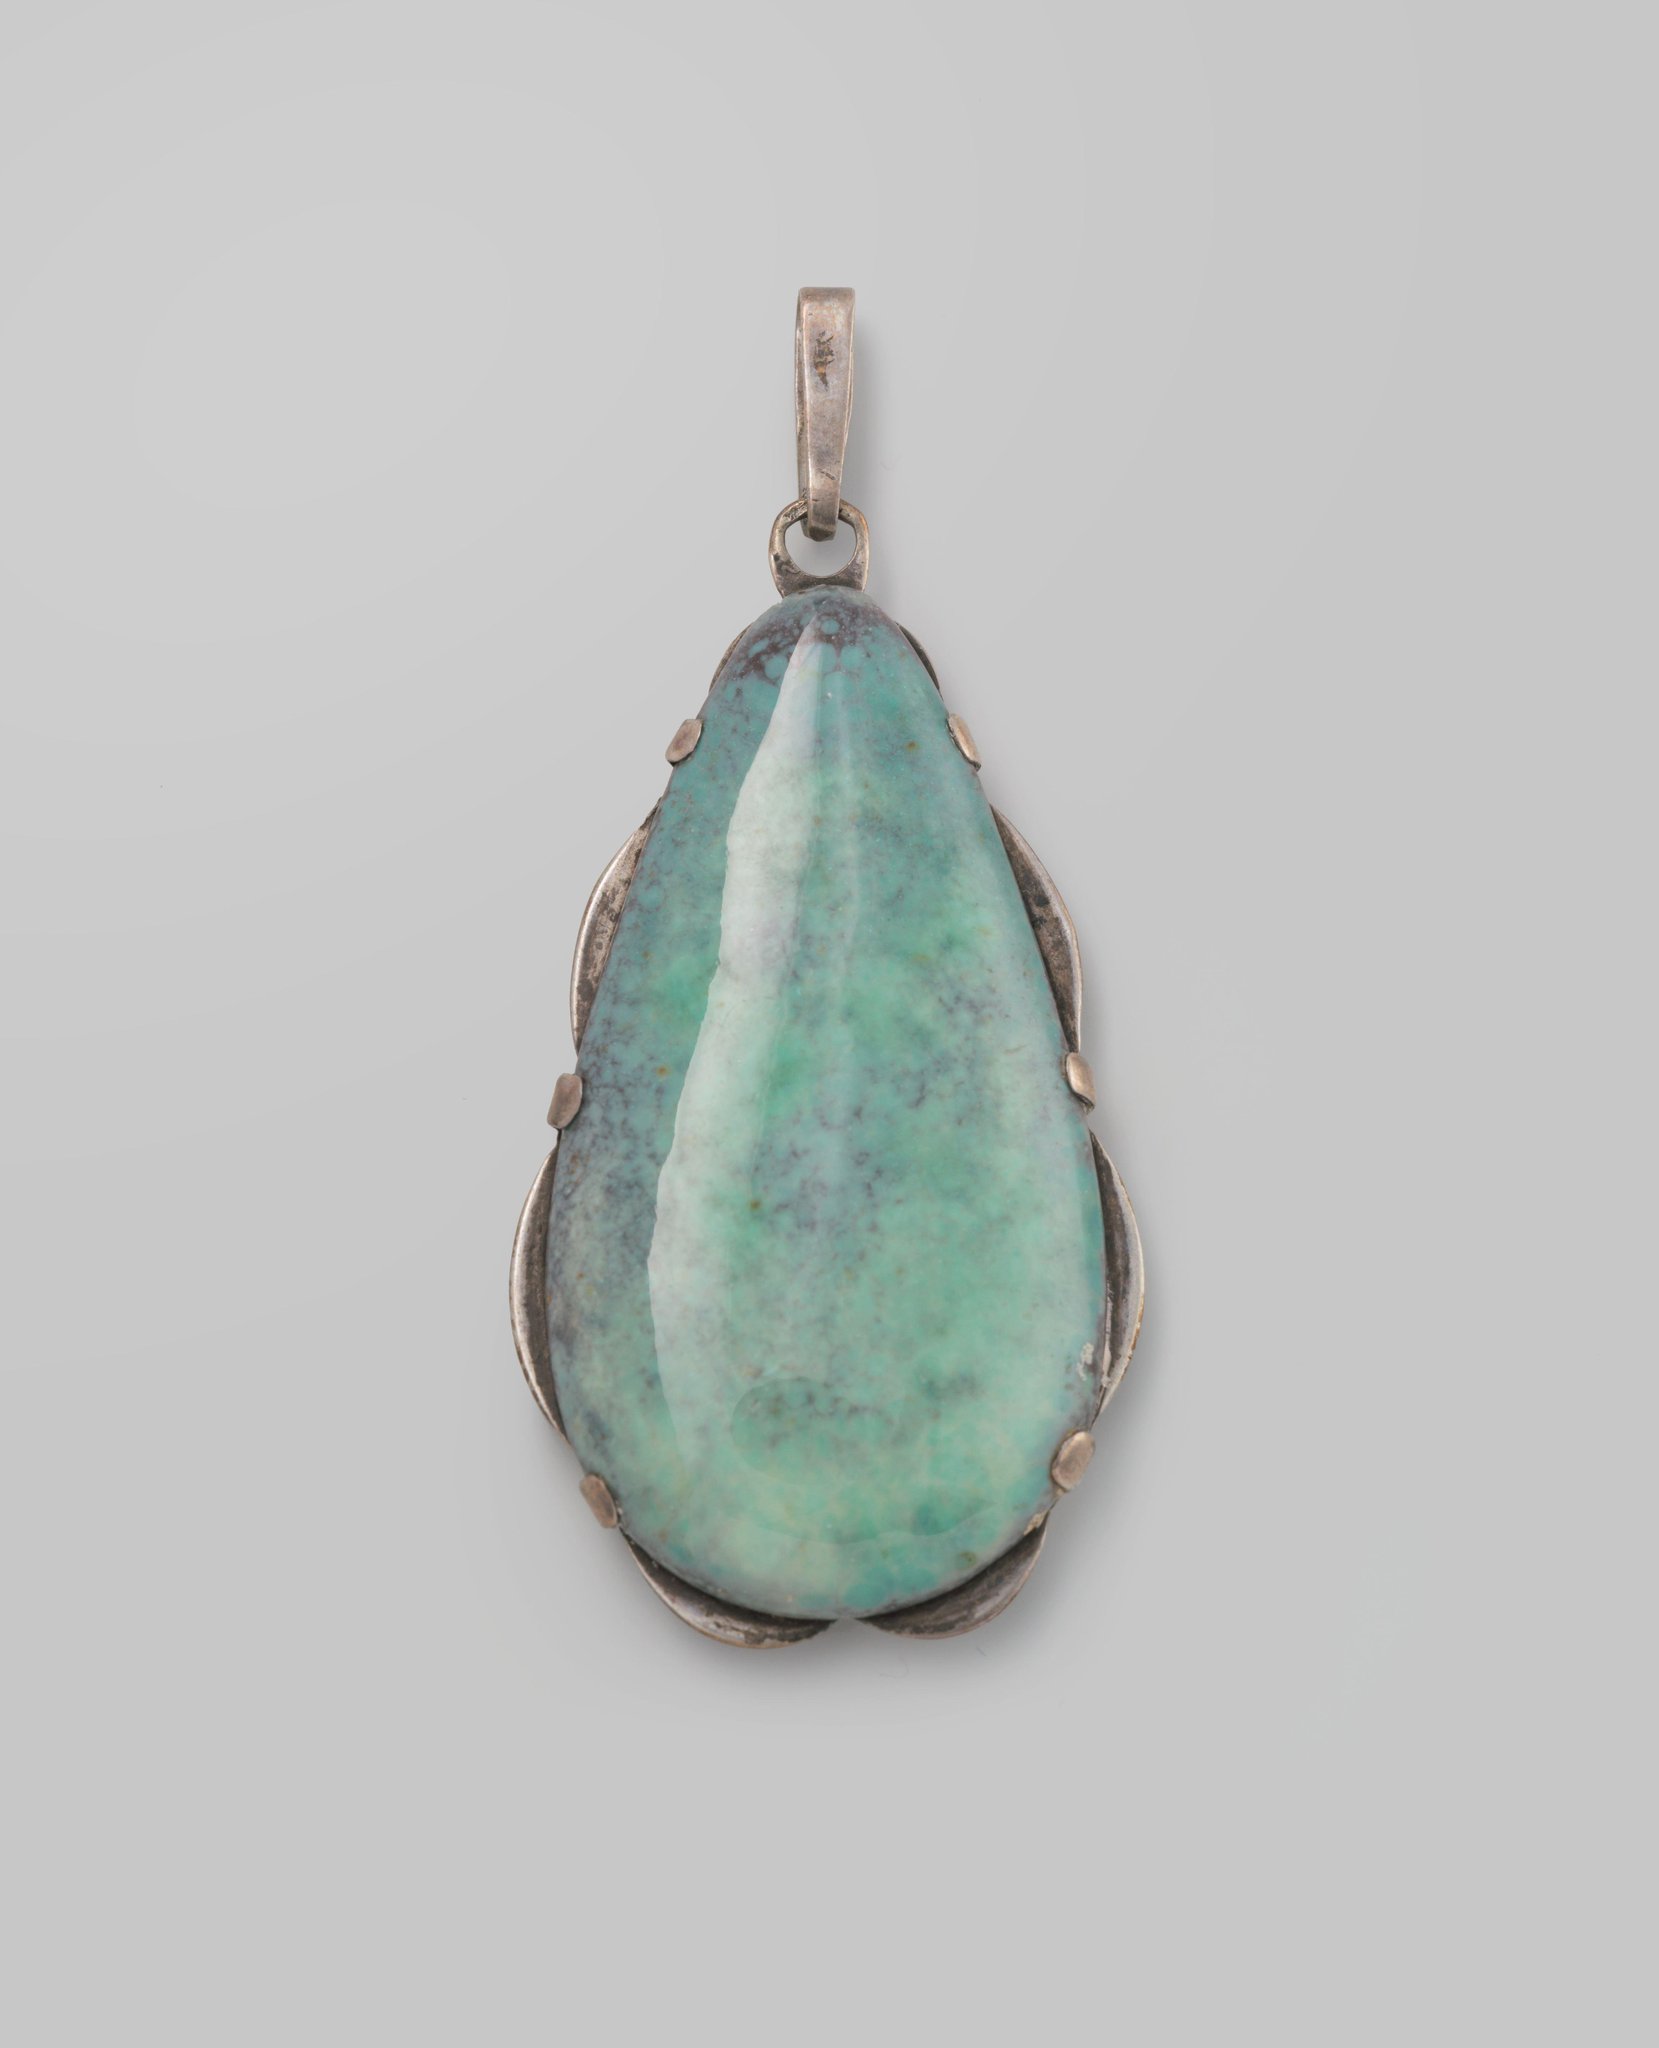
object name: pendant jewelry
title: Hanger van zilver met druppelvormige groene aventurijnkwarts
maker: Anonymous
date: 1930-1950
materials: quartz, silver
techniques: grinding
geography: netherlands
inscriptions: : ‘I’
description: Hanger van zilver met druppelvormige groene cabochon geslepen aventurijnkwarts voorzien van een plaatoog.